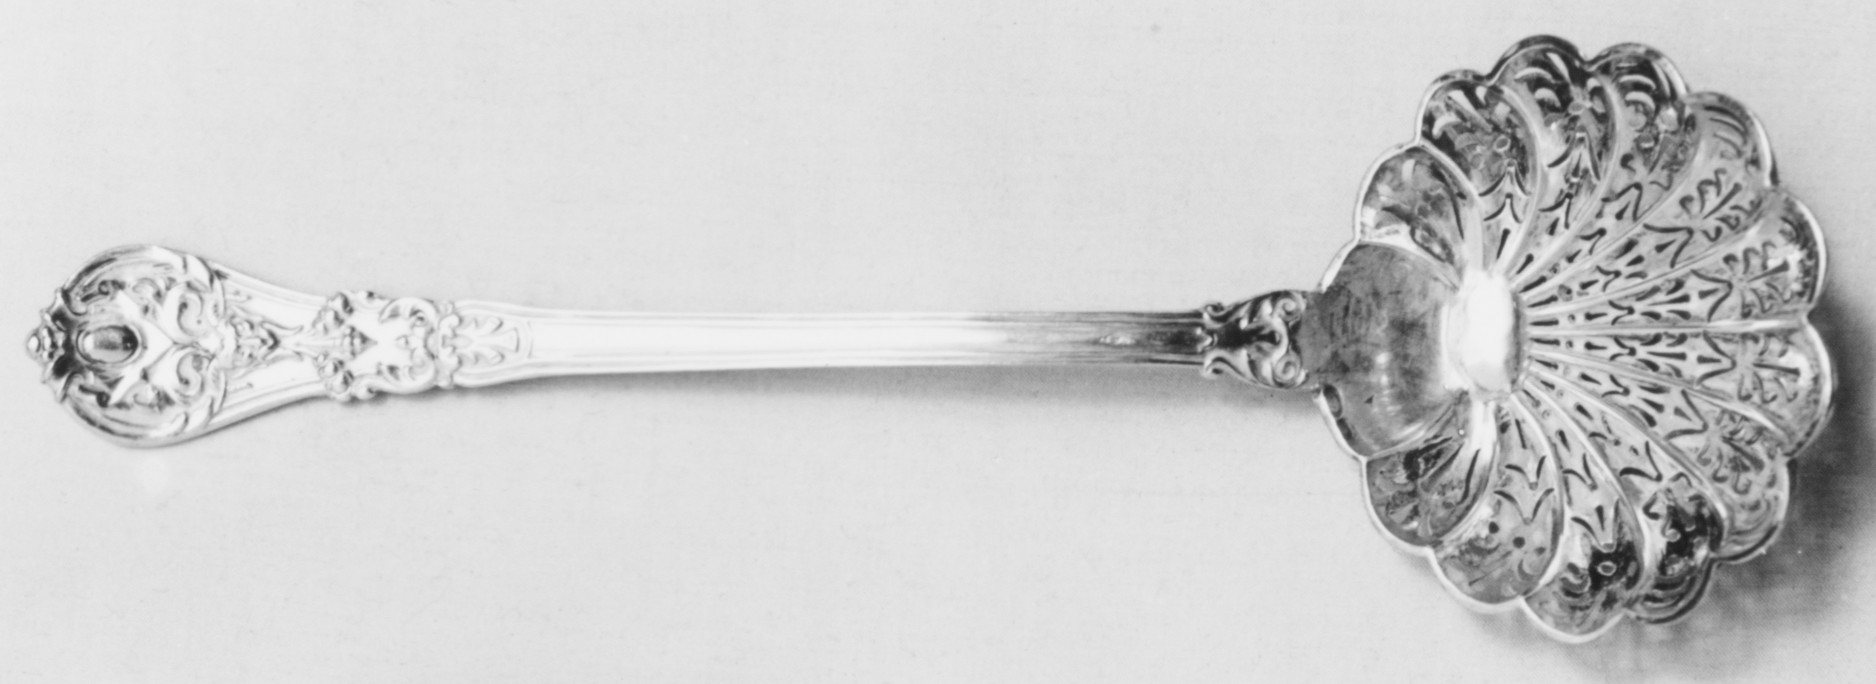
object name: sugar sifter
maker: louis béguin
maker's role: maker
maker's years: 1808-1908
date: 1851-1900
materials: silver